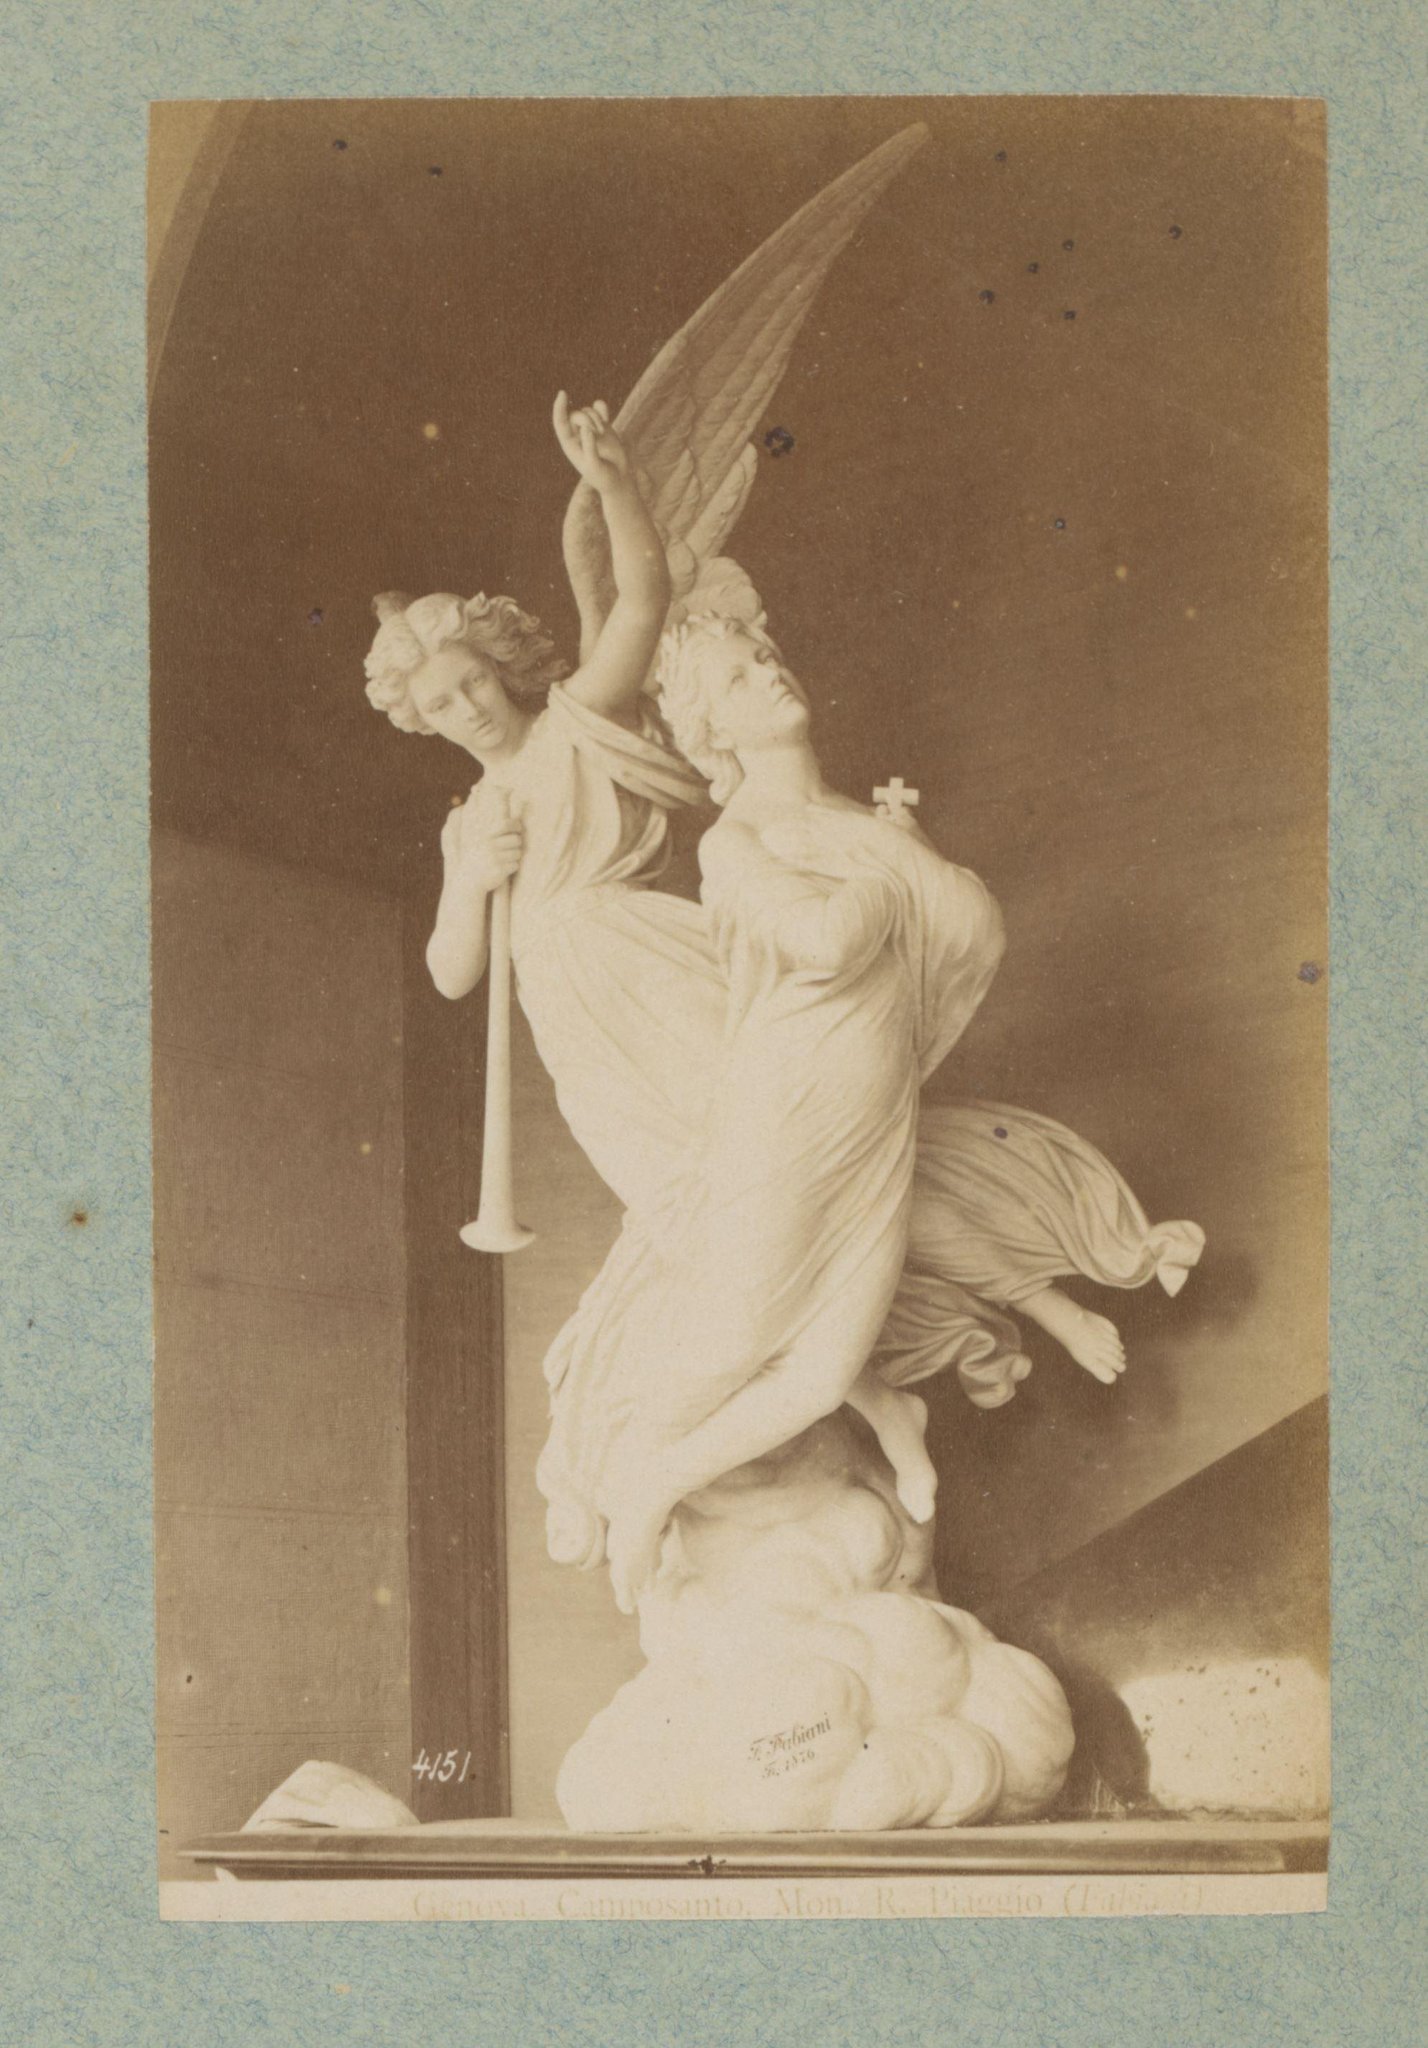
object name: photograph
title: Grafmonument voor Piaggio naar Federico Fabiani op de begraafplaats van Staglieno te Genua, Italië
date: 1876-1890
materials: cardboard, paper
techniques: albumen print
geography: genoa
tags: sculpture, grave-building, monumental tomb, angels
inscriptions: number: ‘4151’, collector's mark: ‘VOSMAER’